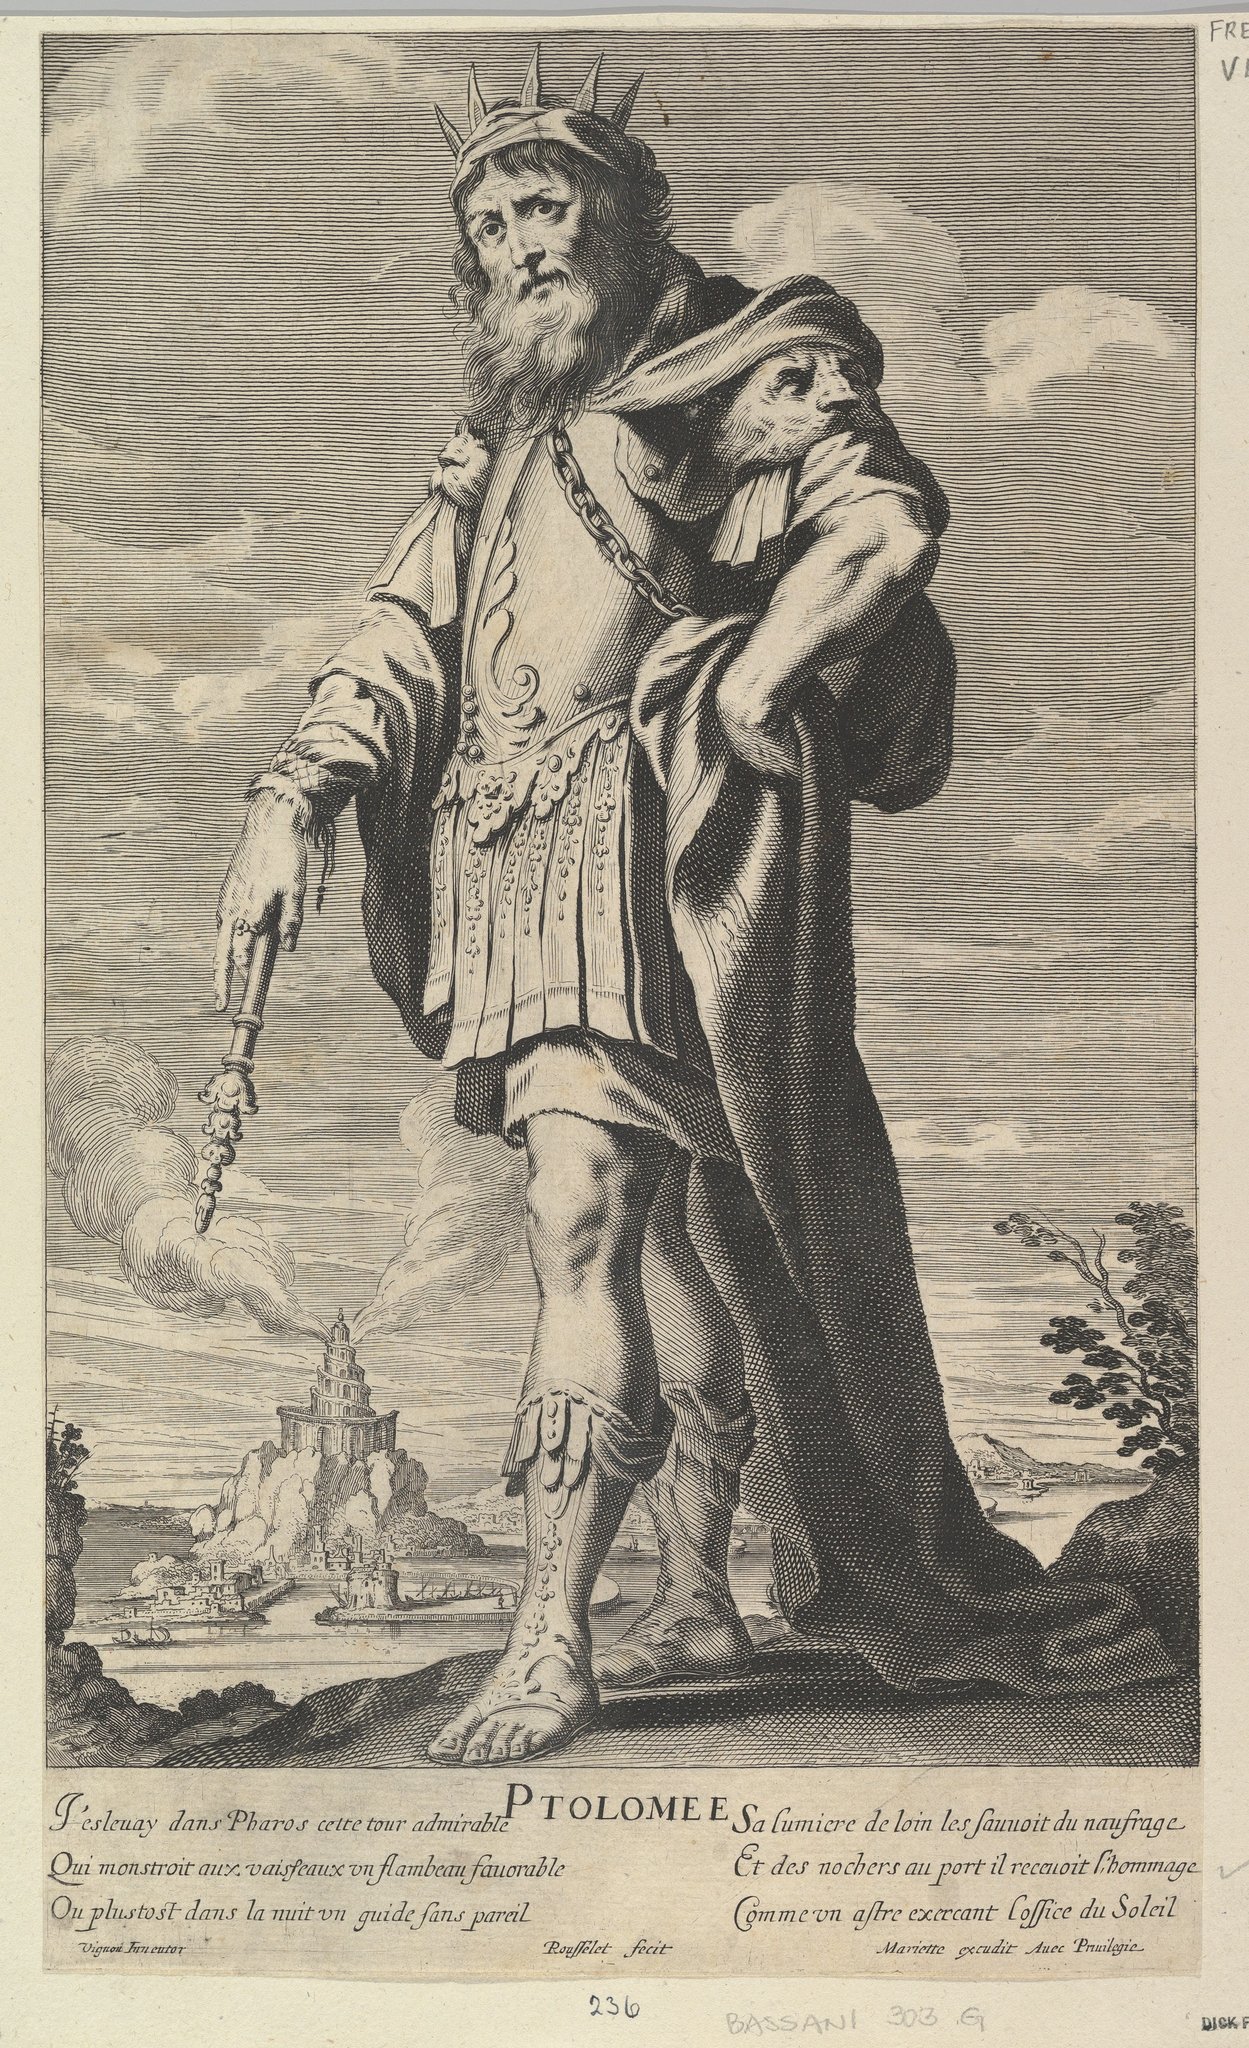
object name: print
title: Ptolémée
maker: gilles rousselet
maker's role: artist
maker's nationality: french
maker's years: 1614-1686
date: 1639-1640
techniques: engraving, etching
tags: men,portraits